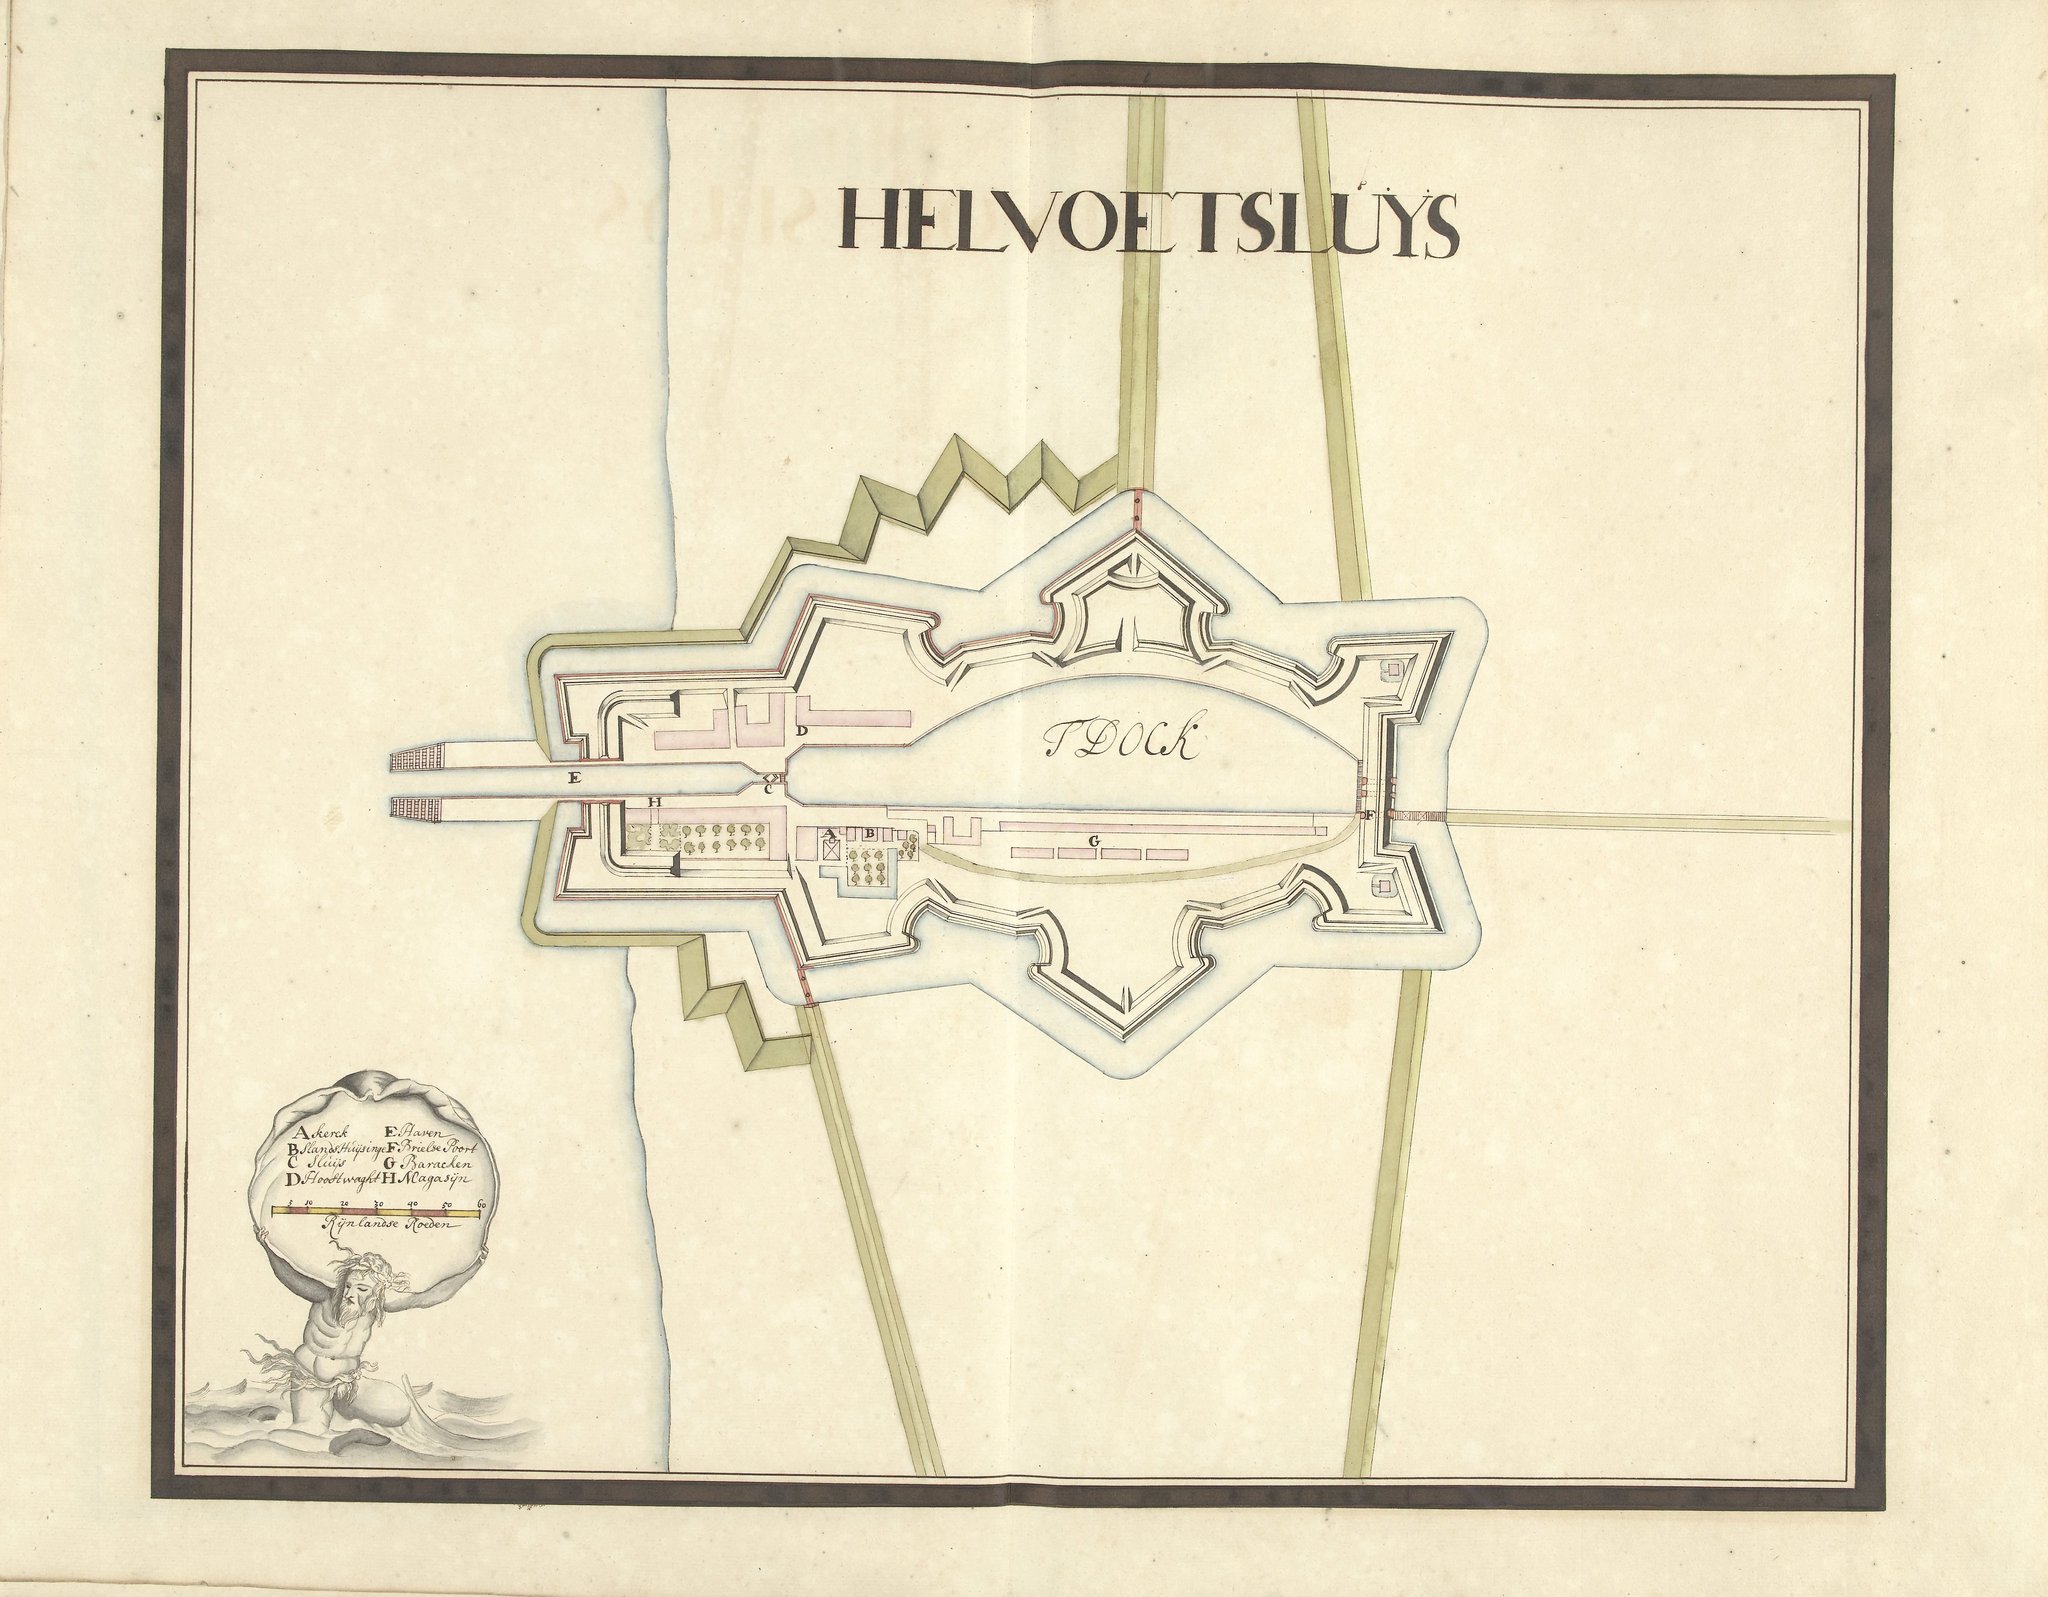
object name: drawing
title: Plattegrond van Hellevoetsluis, ca. 1701-1715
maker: samuel du ry de champdoré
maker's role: draughtsman, engineer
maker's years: 1651-1729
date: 1701-1715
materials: paper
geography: netherlands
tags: fortress, maps of cities, hellevoetsluis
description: Plattegrond van de versterkingen om de stad Hellevoetsluis, ca. 1701-1715. Linksonder een cartouche met de legenda A-H in het Nederlands, op de schouders gedragen door een zeegod. Onderdeel van een verzameling getekende plannen van versterkte plaatsen in Nederland en omringende landen ten tijde van de Spaanse Successieoorlog (deel A).